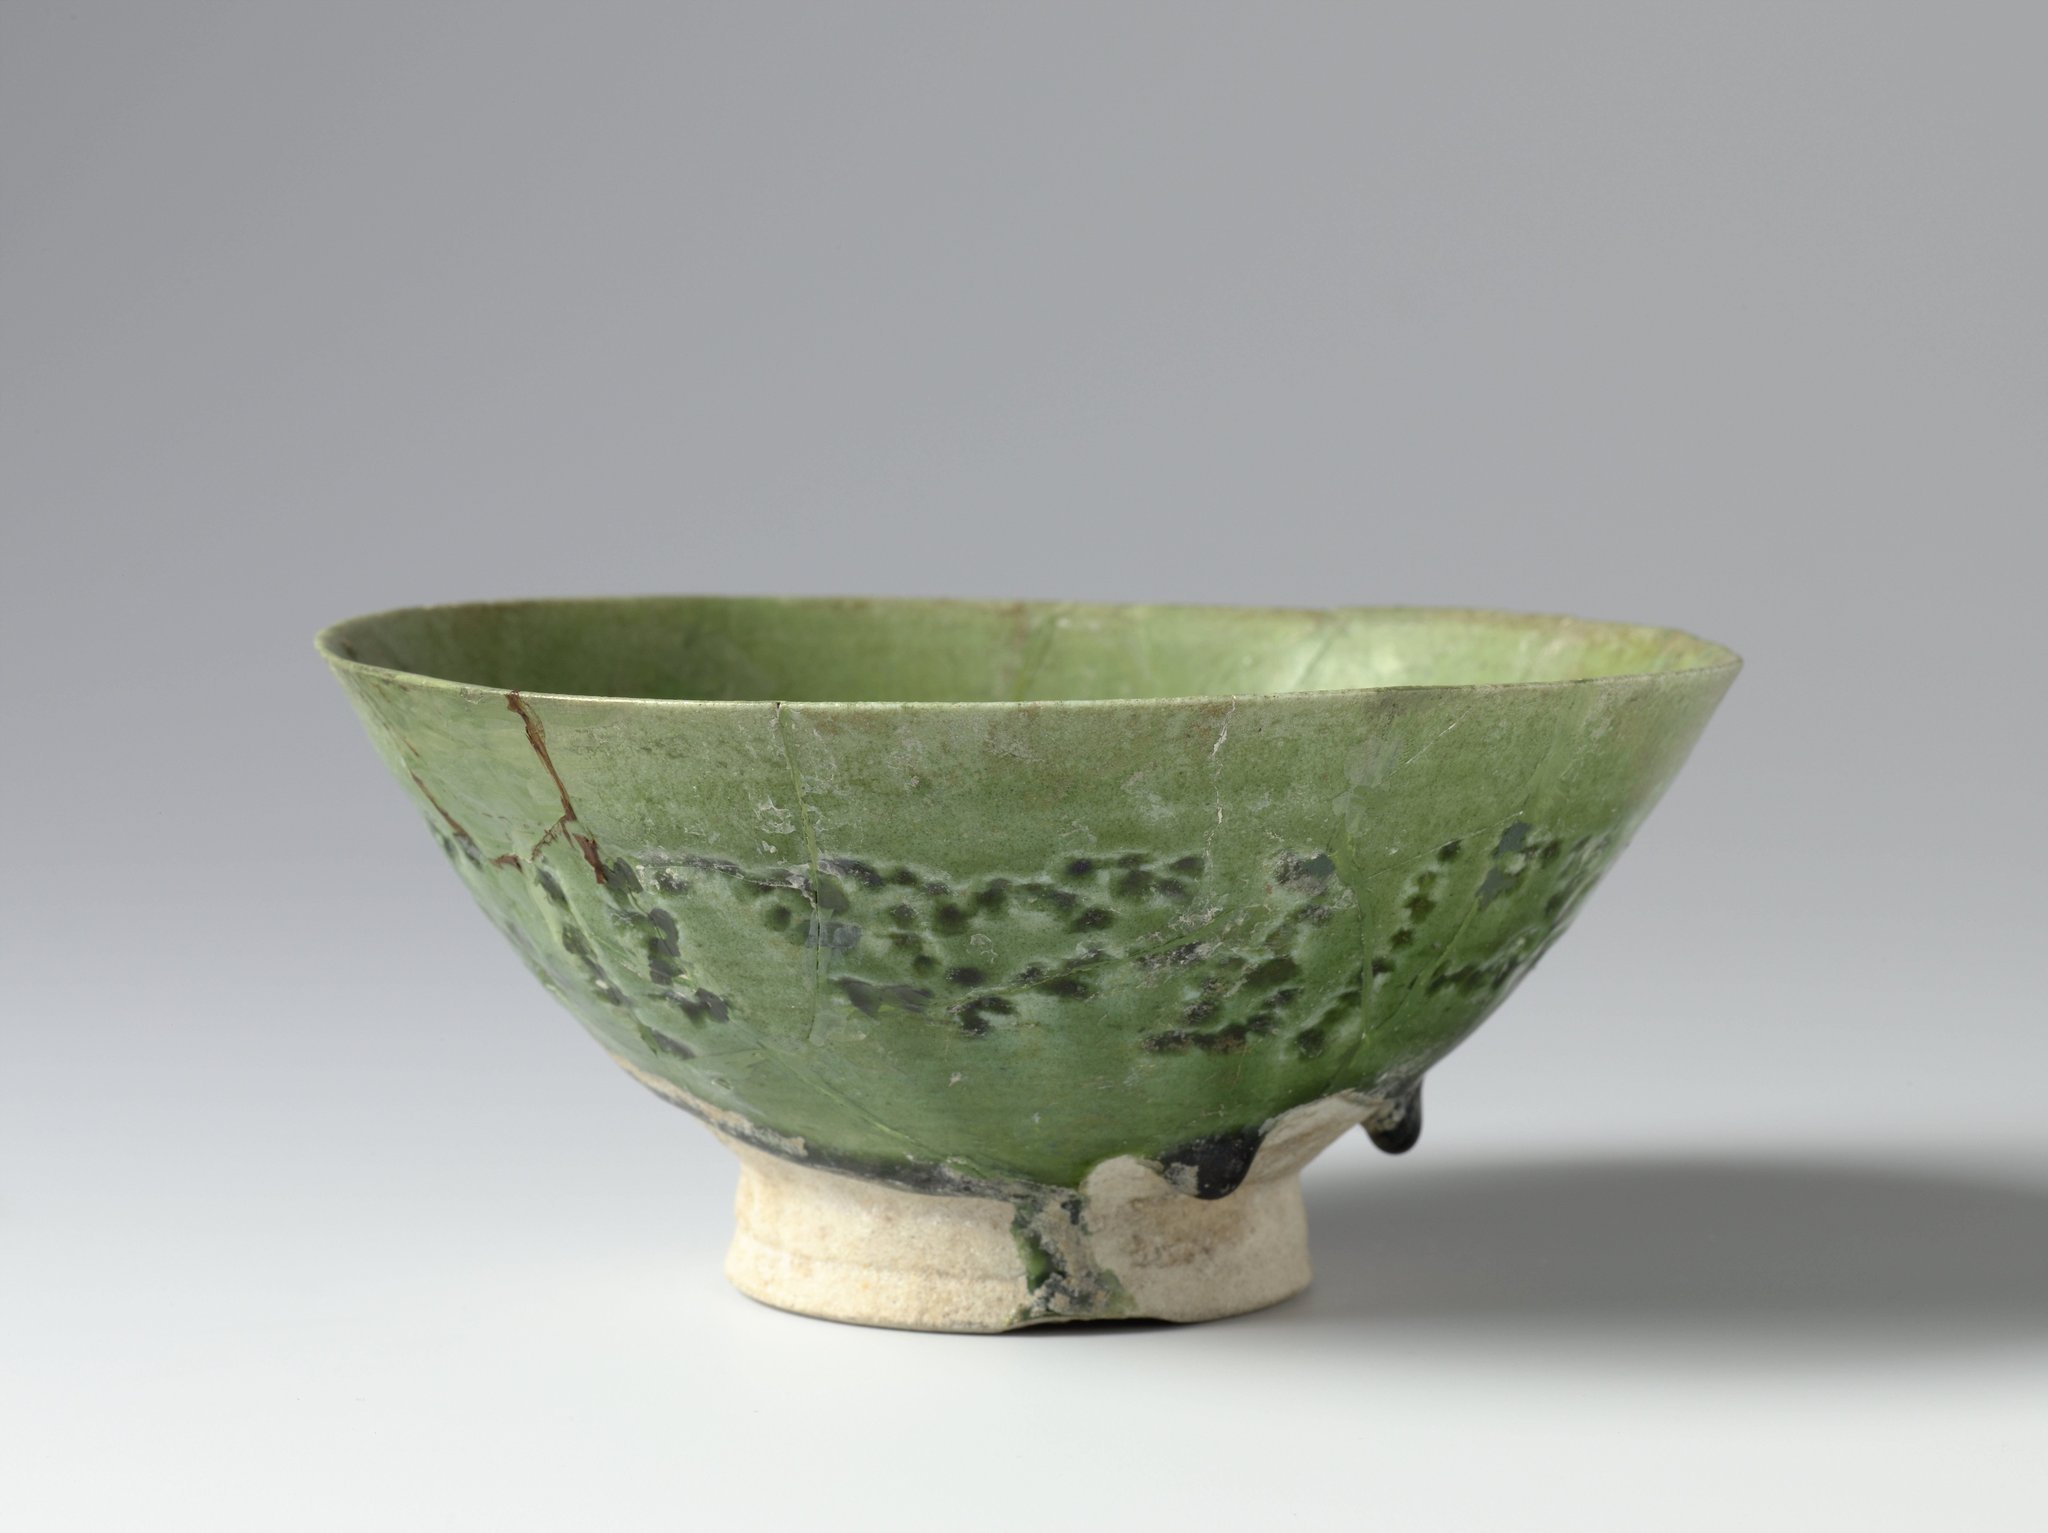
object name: bowl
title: Bowl with incised scrolls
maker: Anonymous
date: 1175-1224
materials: earthenware, glaze, quartz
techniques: firing, perforating, turning, vitrification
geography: iran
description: Kom van kwarts-fritgoed gedecoreerd met een ingegrifte vakdecoratie met ranken en geperforeerd met kleine gaatjes waarop een monochrome groene alkaliglazuur is aangebracht.